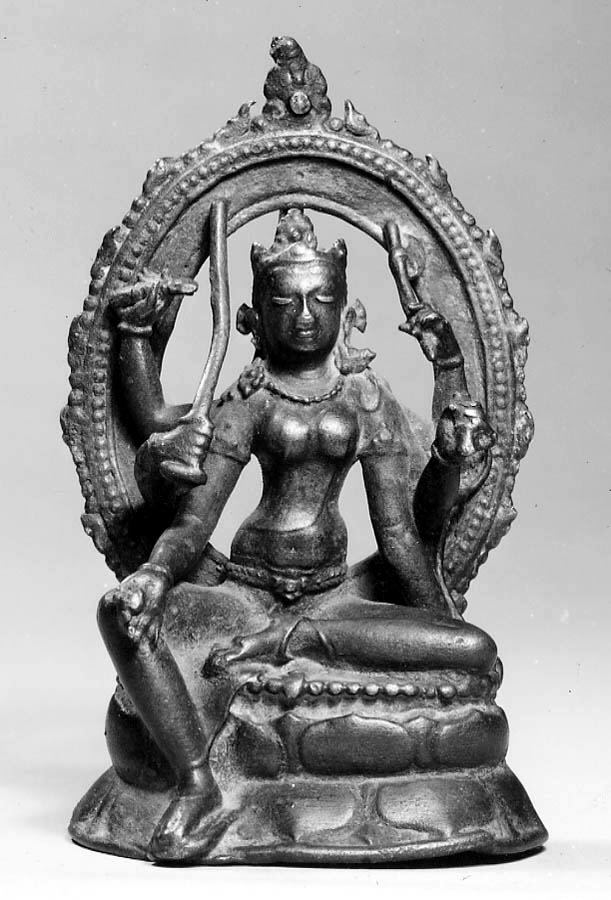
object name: figure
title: Seated Tara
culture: indian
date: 901-1000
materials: bronze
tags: buddhism,deities